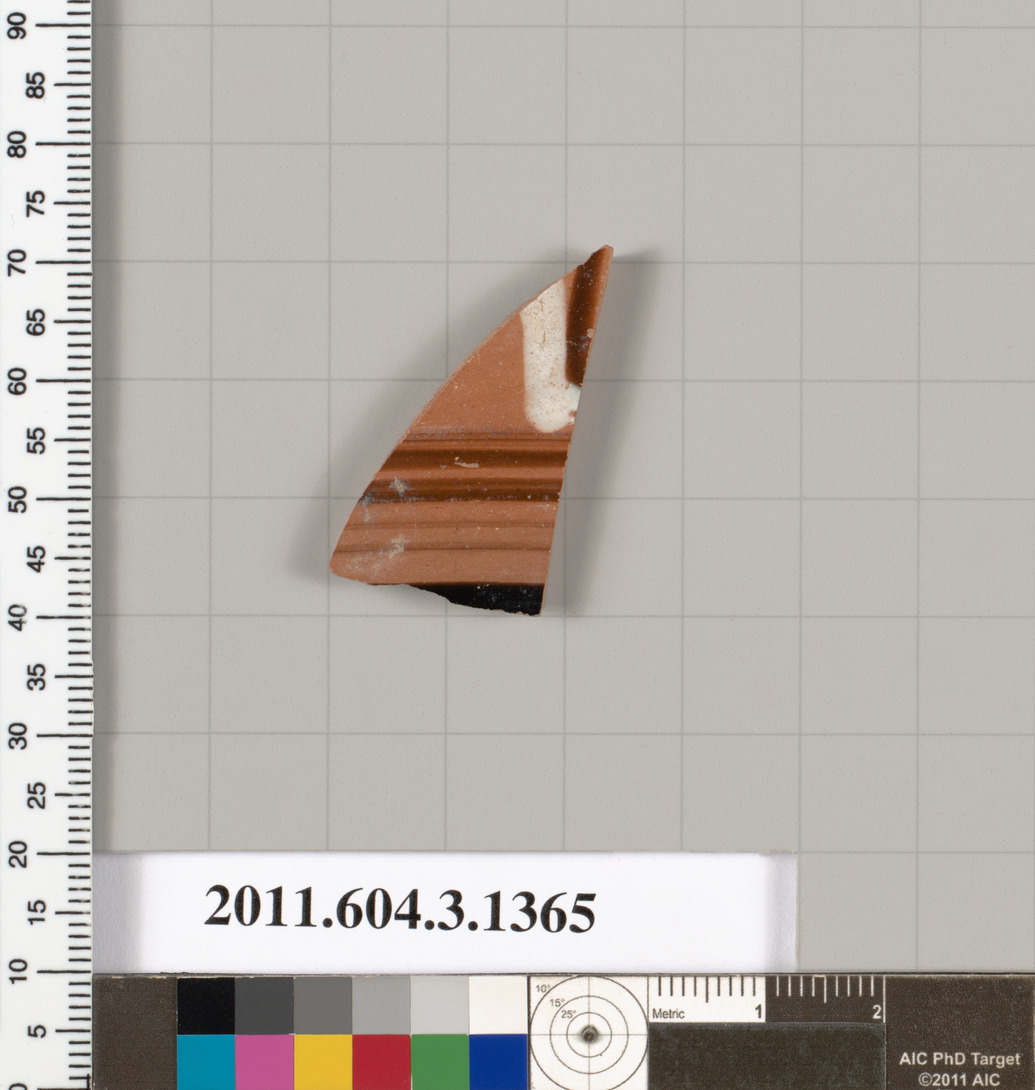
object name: skyphos fragment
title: Terracotta fragment of a skyphos (deep drinking cup)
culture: greek, attic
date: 500-468 BCE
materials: terracotta